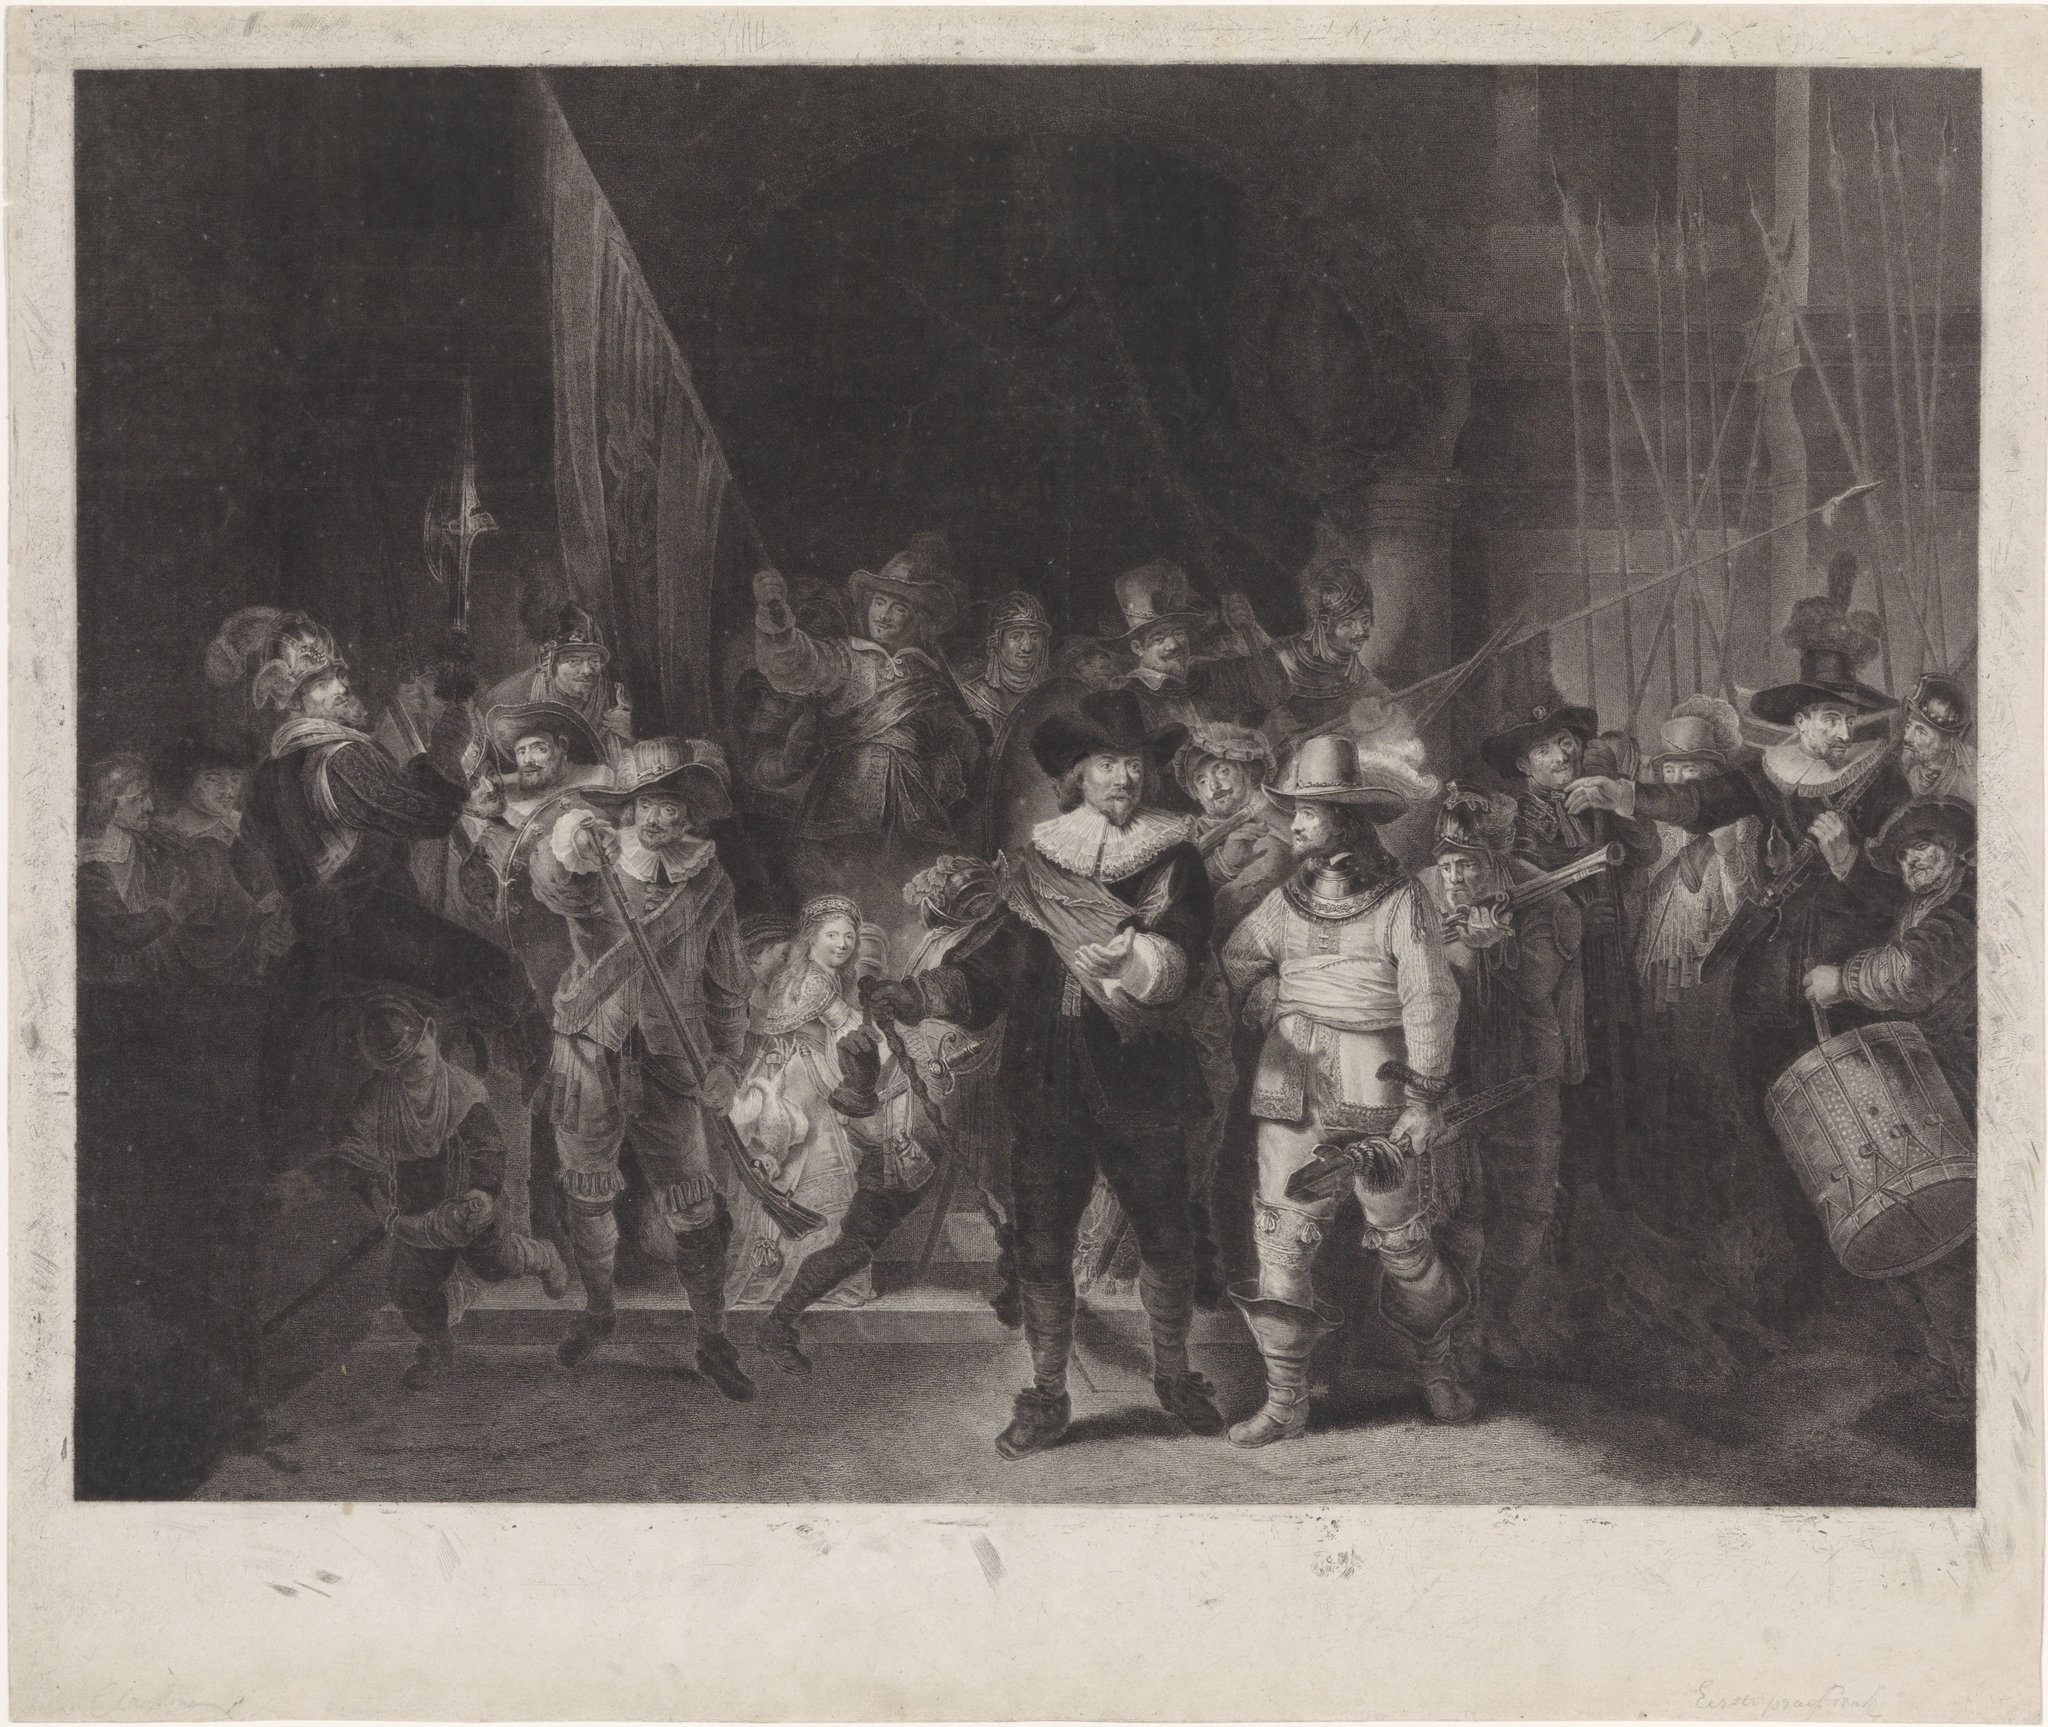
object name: print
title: De nachtwacht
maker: lambertus antonius claessens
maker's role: draughtsman, print maker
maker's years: 1763-1834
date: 1797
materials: paper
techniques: etching, roulette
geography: amsterdam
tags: defence of fortification or city (+ auxiliary corps)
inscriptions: collector's mark: Lugt 12, collector's mark: Lugt 2165